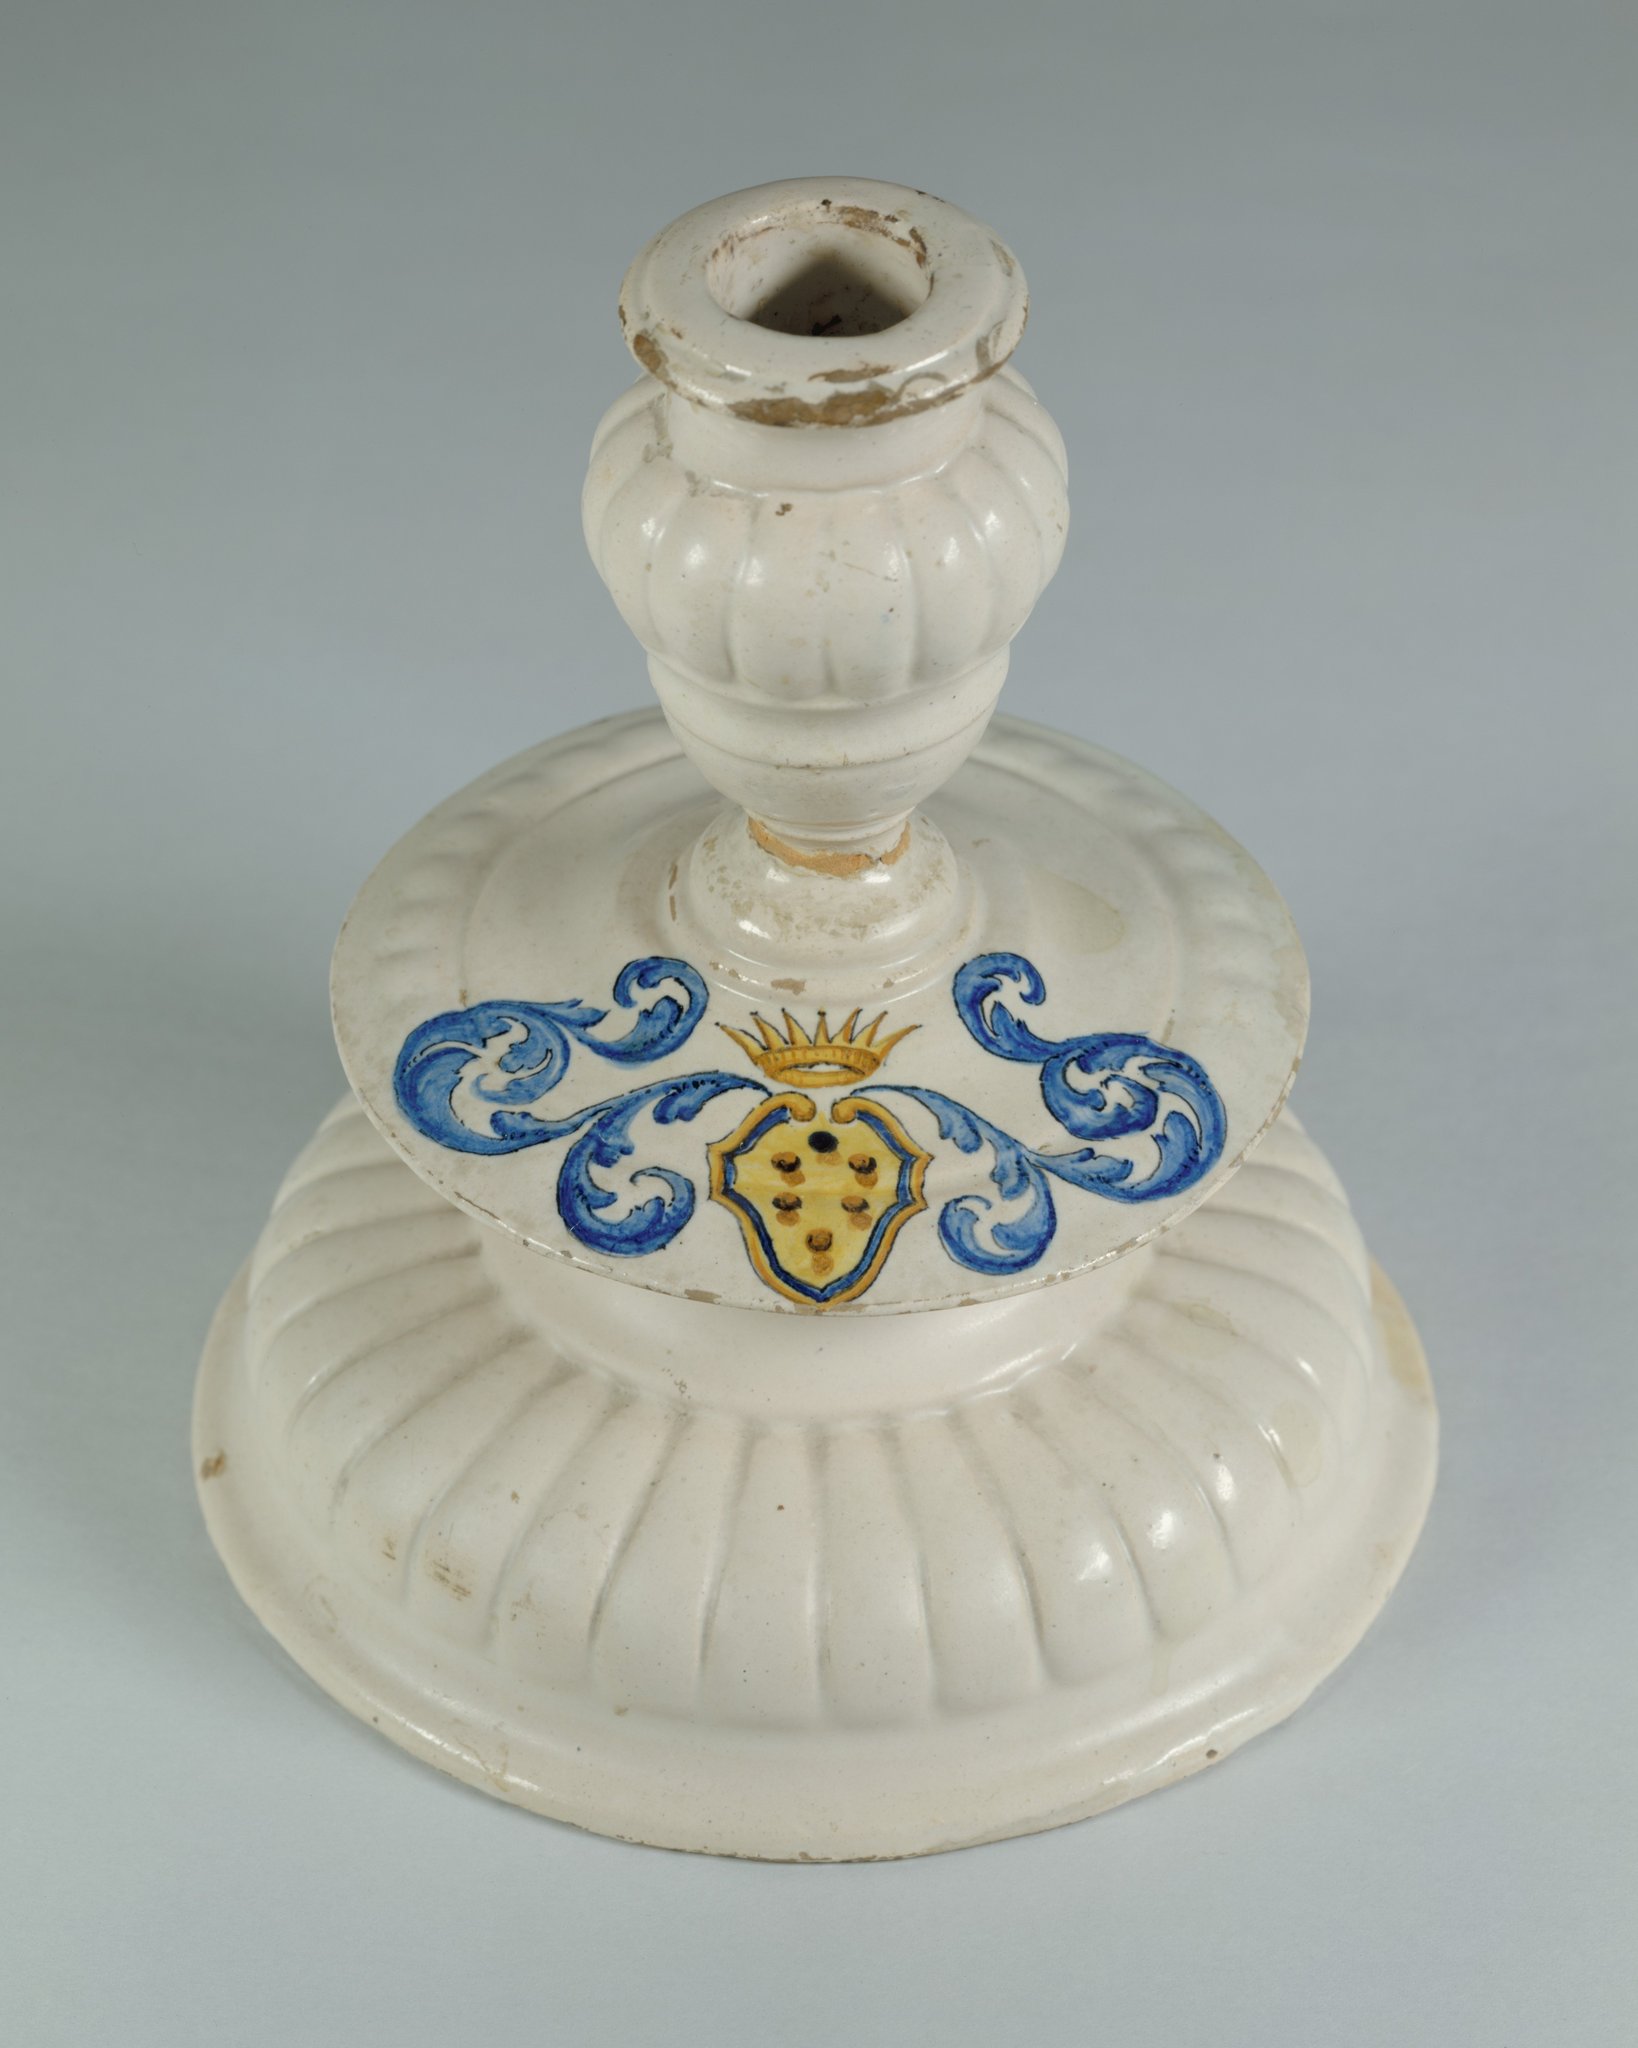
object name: candlestick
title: Candlestick (candeliere)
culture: italian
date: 1634-1666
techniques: maiolica, glazing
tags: coat of arms